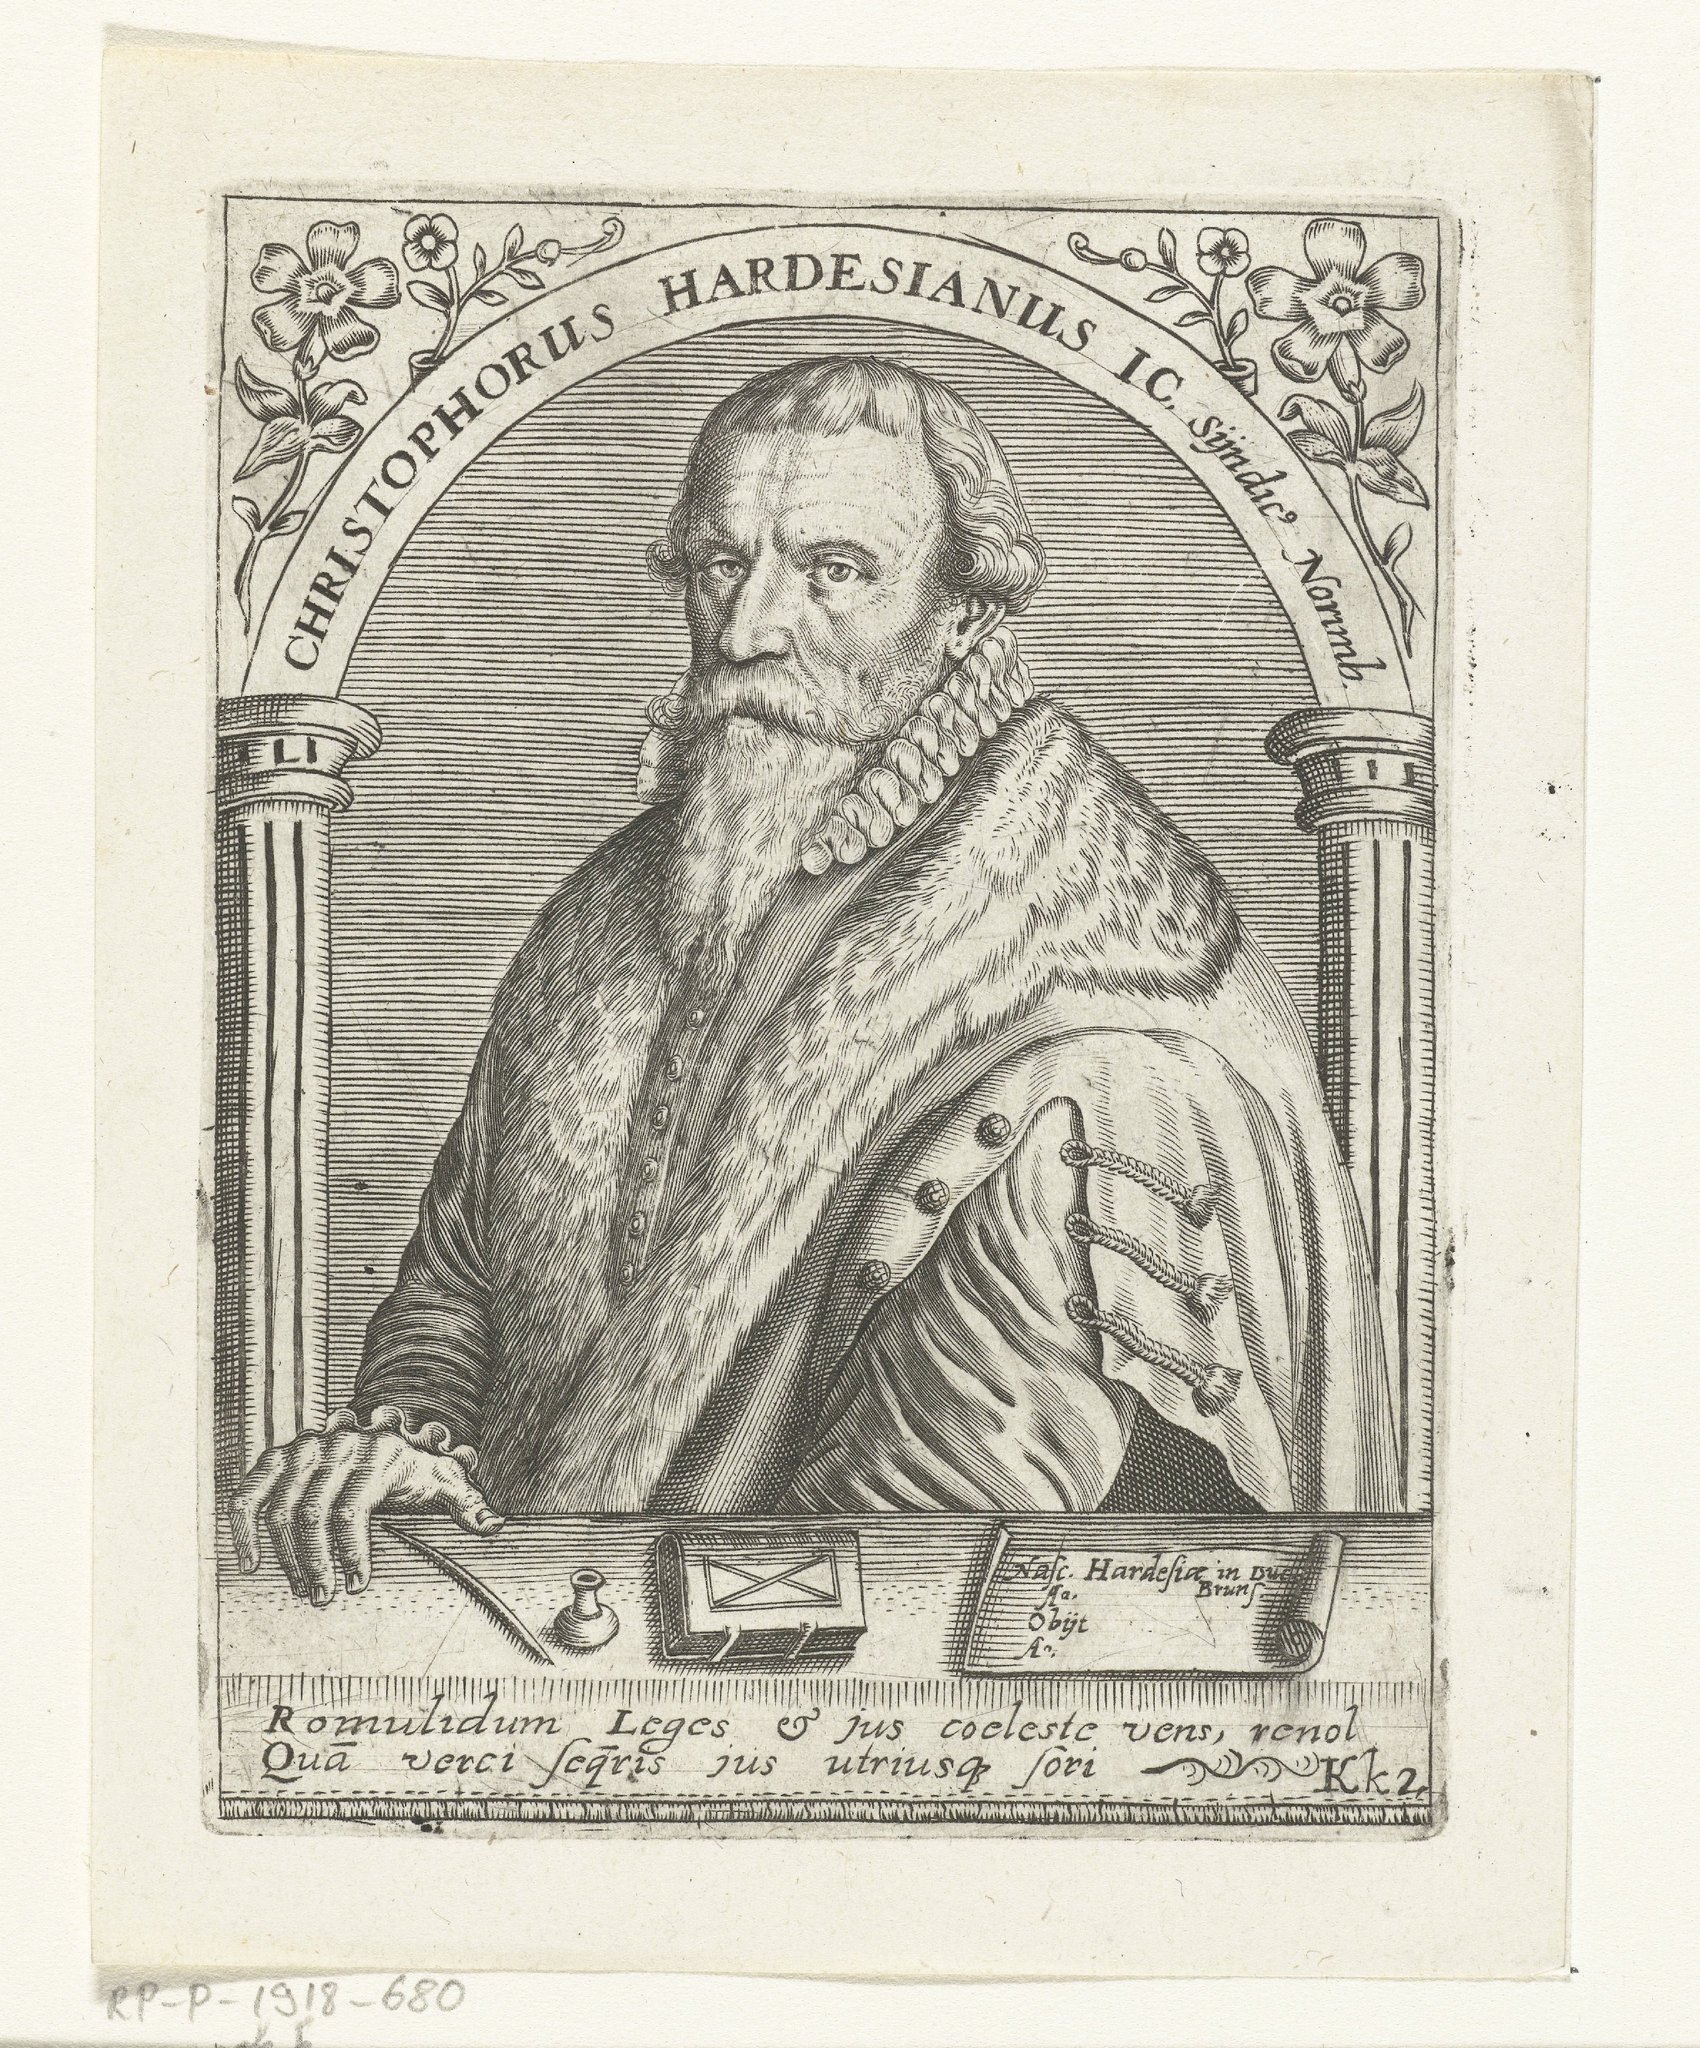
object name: book illustration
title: Portret van Christoph Herdesianus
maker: jean jacques boissard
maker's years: 1528-1598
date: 1669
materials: paper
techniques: engraving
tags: halberstadt, christoph herdesianus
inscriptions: collector's mark: Lugt 2233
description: Gemaakt voor: J.J. Boissard, Icones virorum illustrium doctrina &c eruditione praestanti um contines. Frankfurt am Main: de Bry, 1597-1599. Opnieuw gebruikt in: J.J.Boissard, Bibliotheca chalcographica, hoc est Virtute et eruditione clarorum Virorum Imagines. Heidelberg: Clemens Ammon, 1669 (te herkennen aan de toegevoegde signatuur in de rechter onderhoek: 2K2).